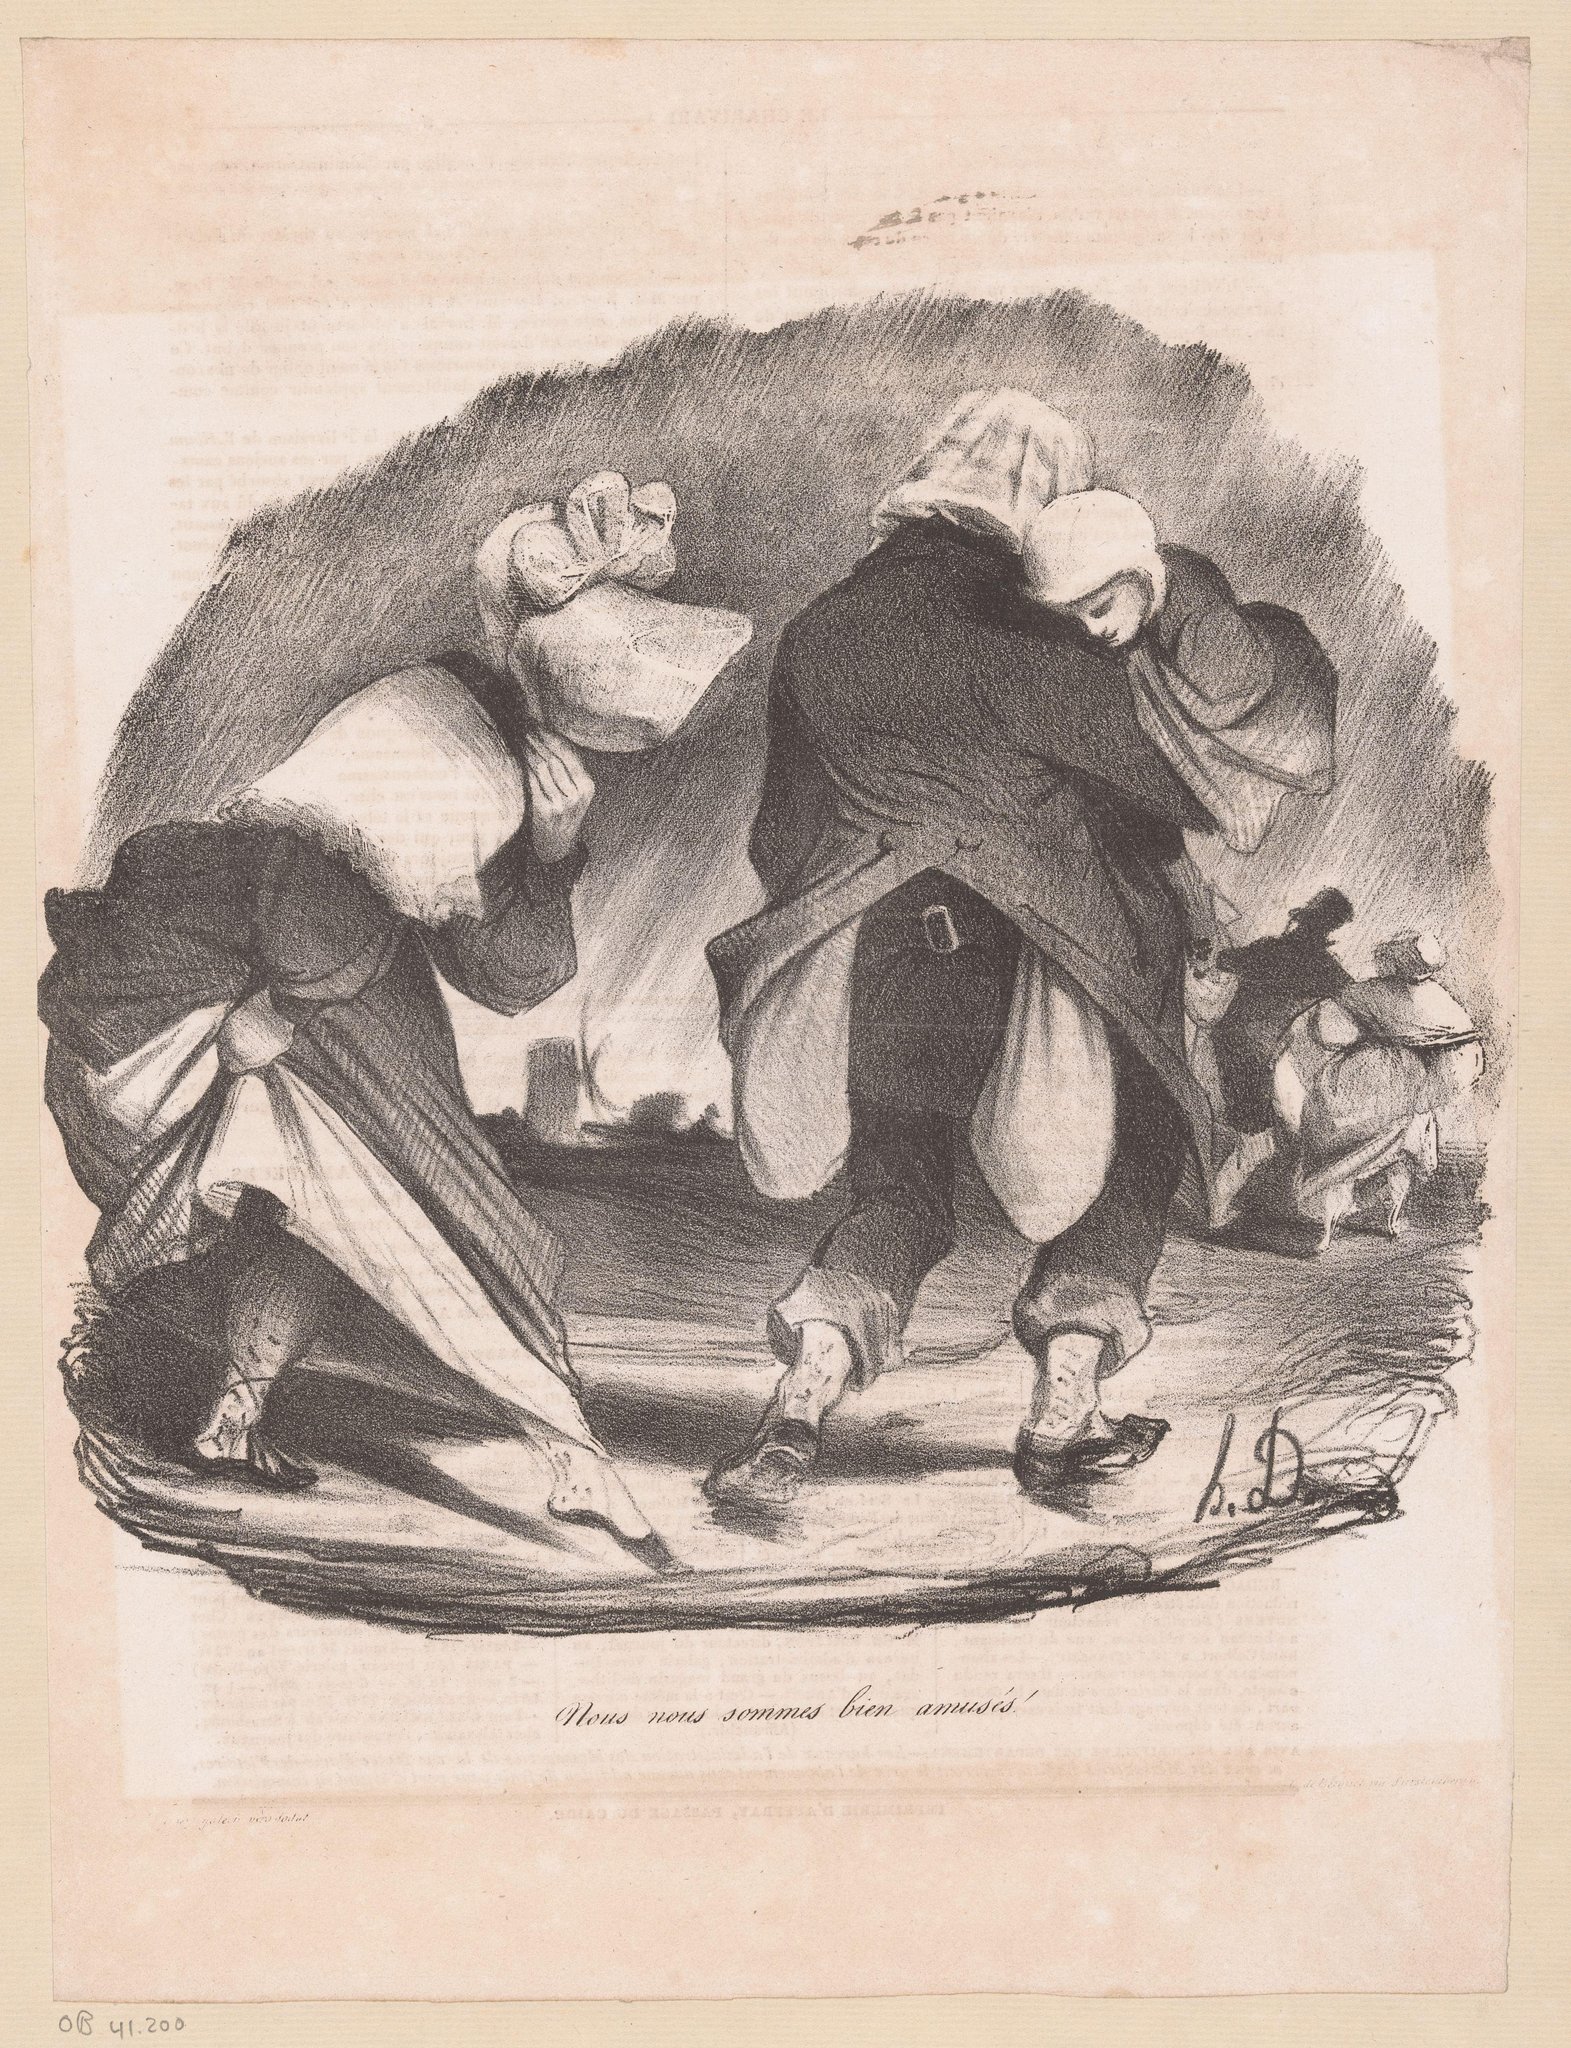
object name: print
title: Nous nous sommes bien amusés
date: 1834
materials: paper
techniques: lithograph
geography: paris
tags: caricatures (human types), family group, especially parents with their child(ren), rain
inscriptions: number: ‘2631’, number: ‘10+’, number: ‘5’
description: Prent gepubliceerd in: Le Charivari, 4 januari 1834. Le Charivari was een humoristische krant met karikaturen en (politieke) cartoons.